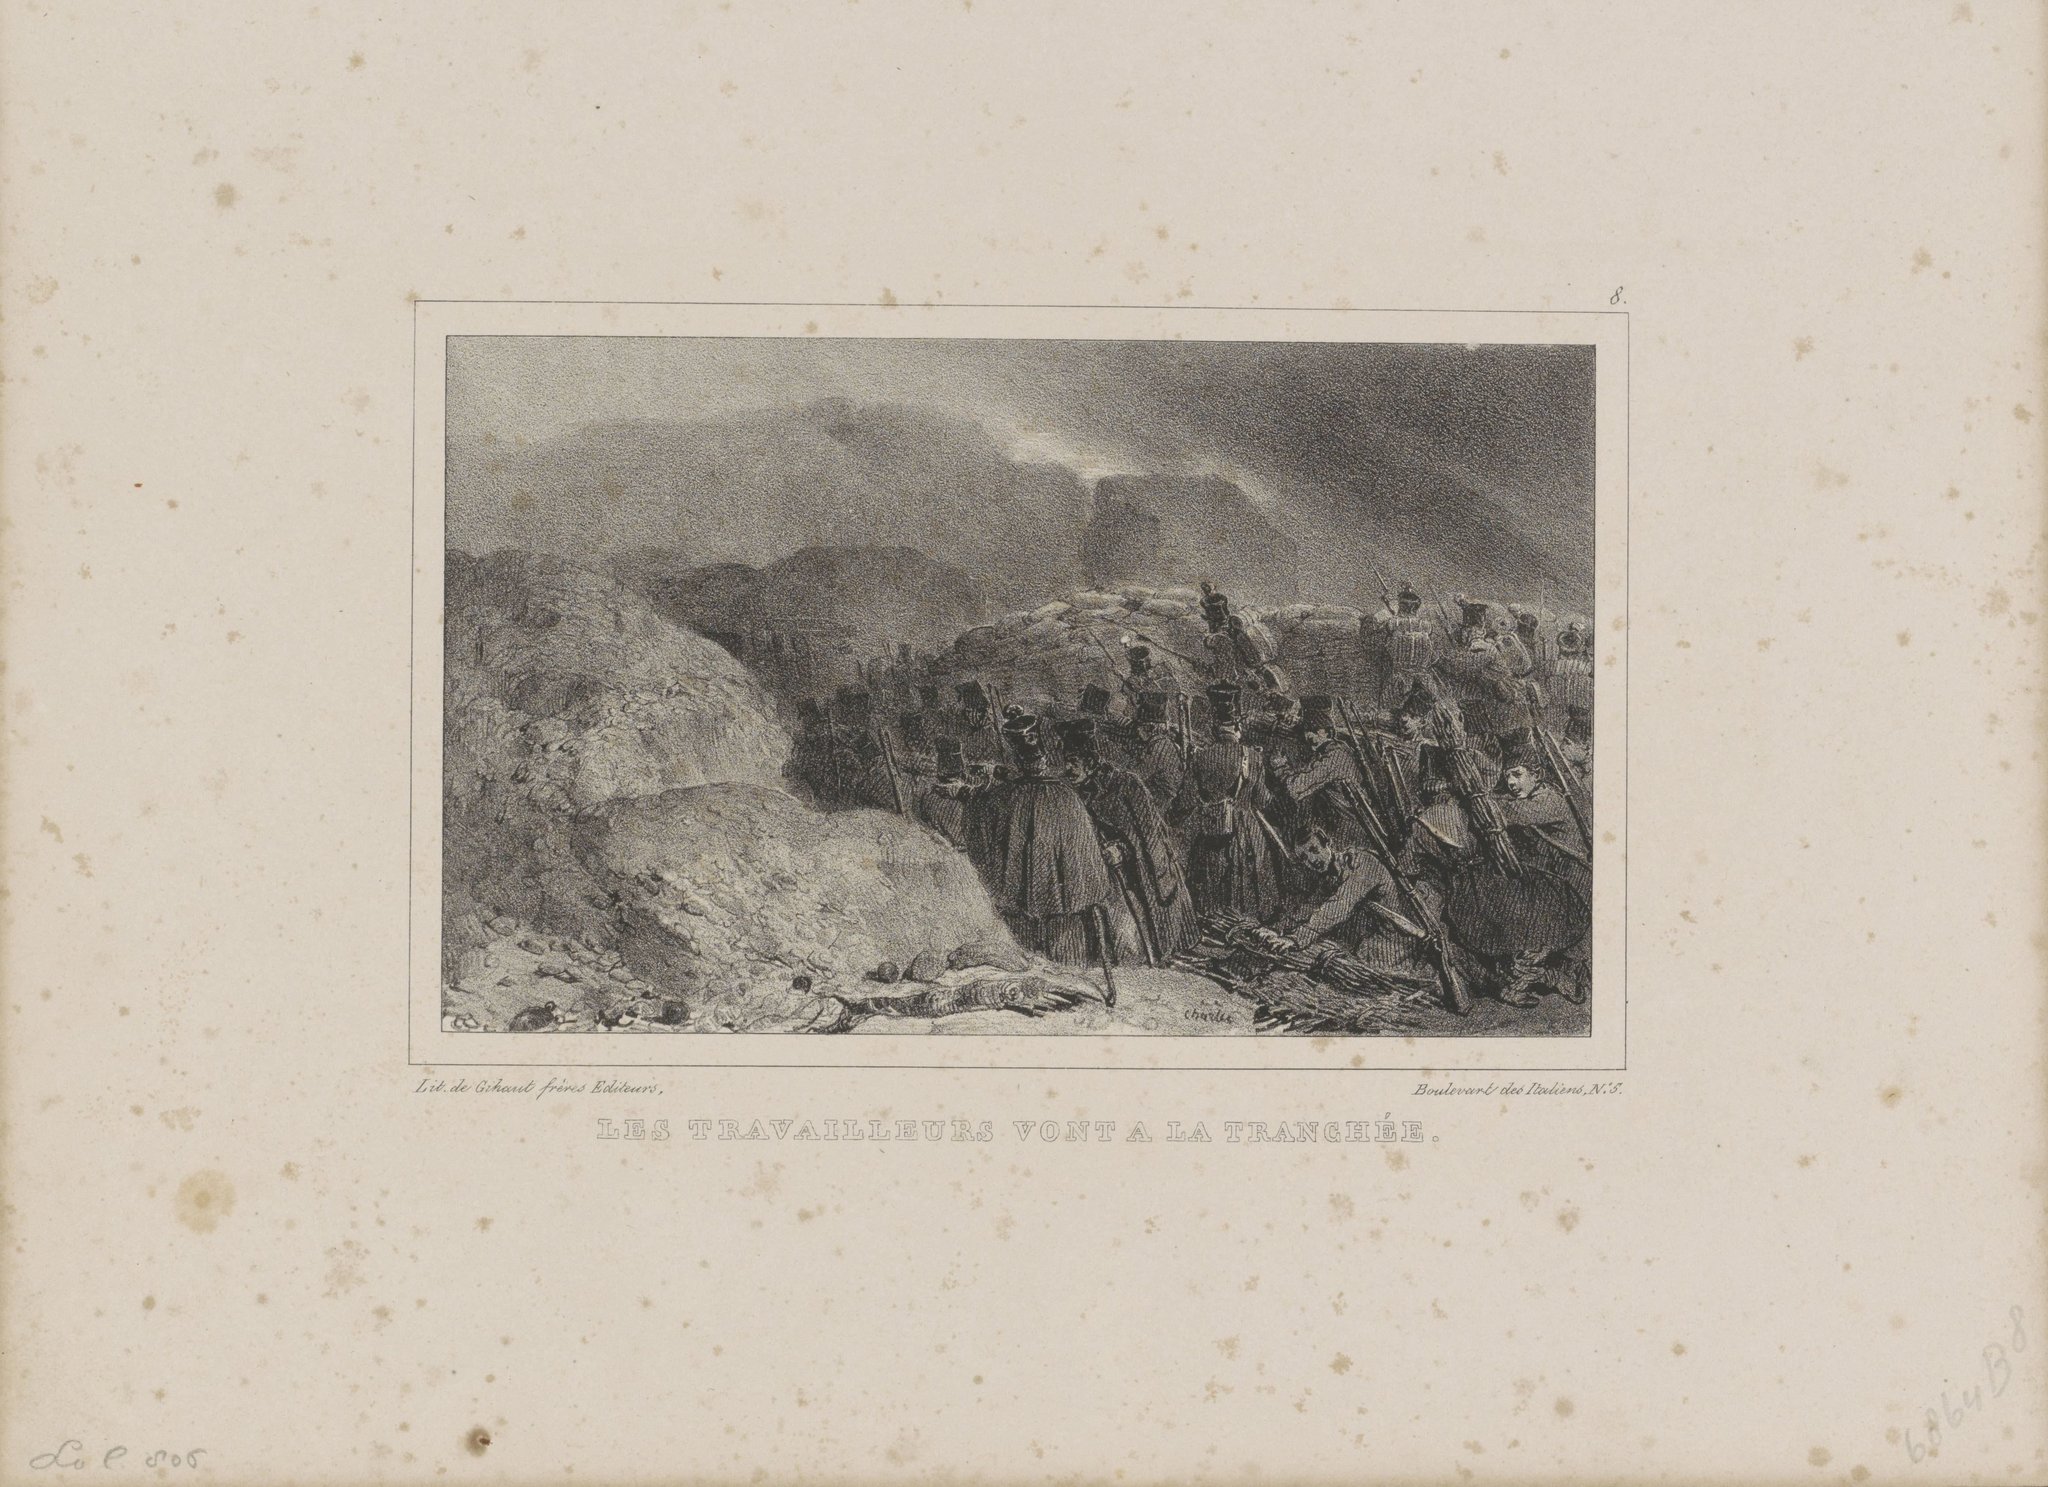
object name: print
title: In de loopgraven, 1832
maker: nicolas toussaint charlet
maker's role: draughtsman, painter, print maker, printer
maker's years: 1792-1845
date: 1832-1833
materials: paper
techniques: lithograph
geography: paris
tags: trenches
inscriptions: collector's mark: Lugt 2228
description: Militairen trekken de loopgraven in, bij de Citadel van Antwerpen, november-december 1832. Onderdeel van een serie van twintig bladen uit 1833 met voorstellingen van de militaire interventie van het Franse Noordelijke Leger in België in 1832.